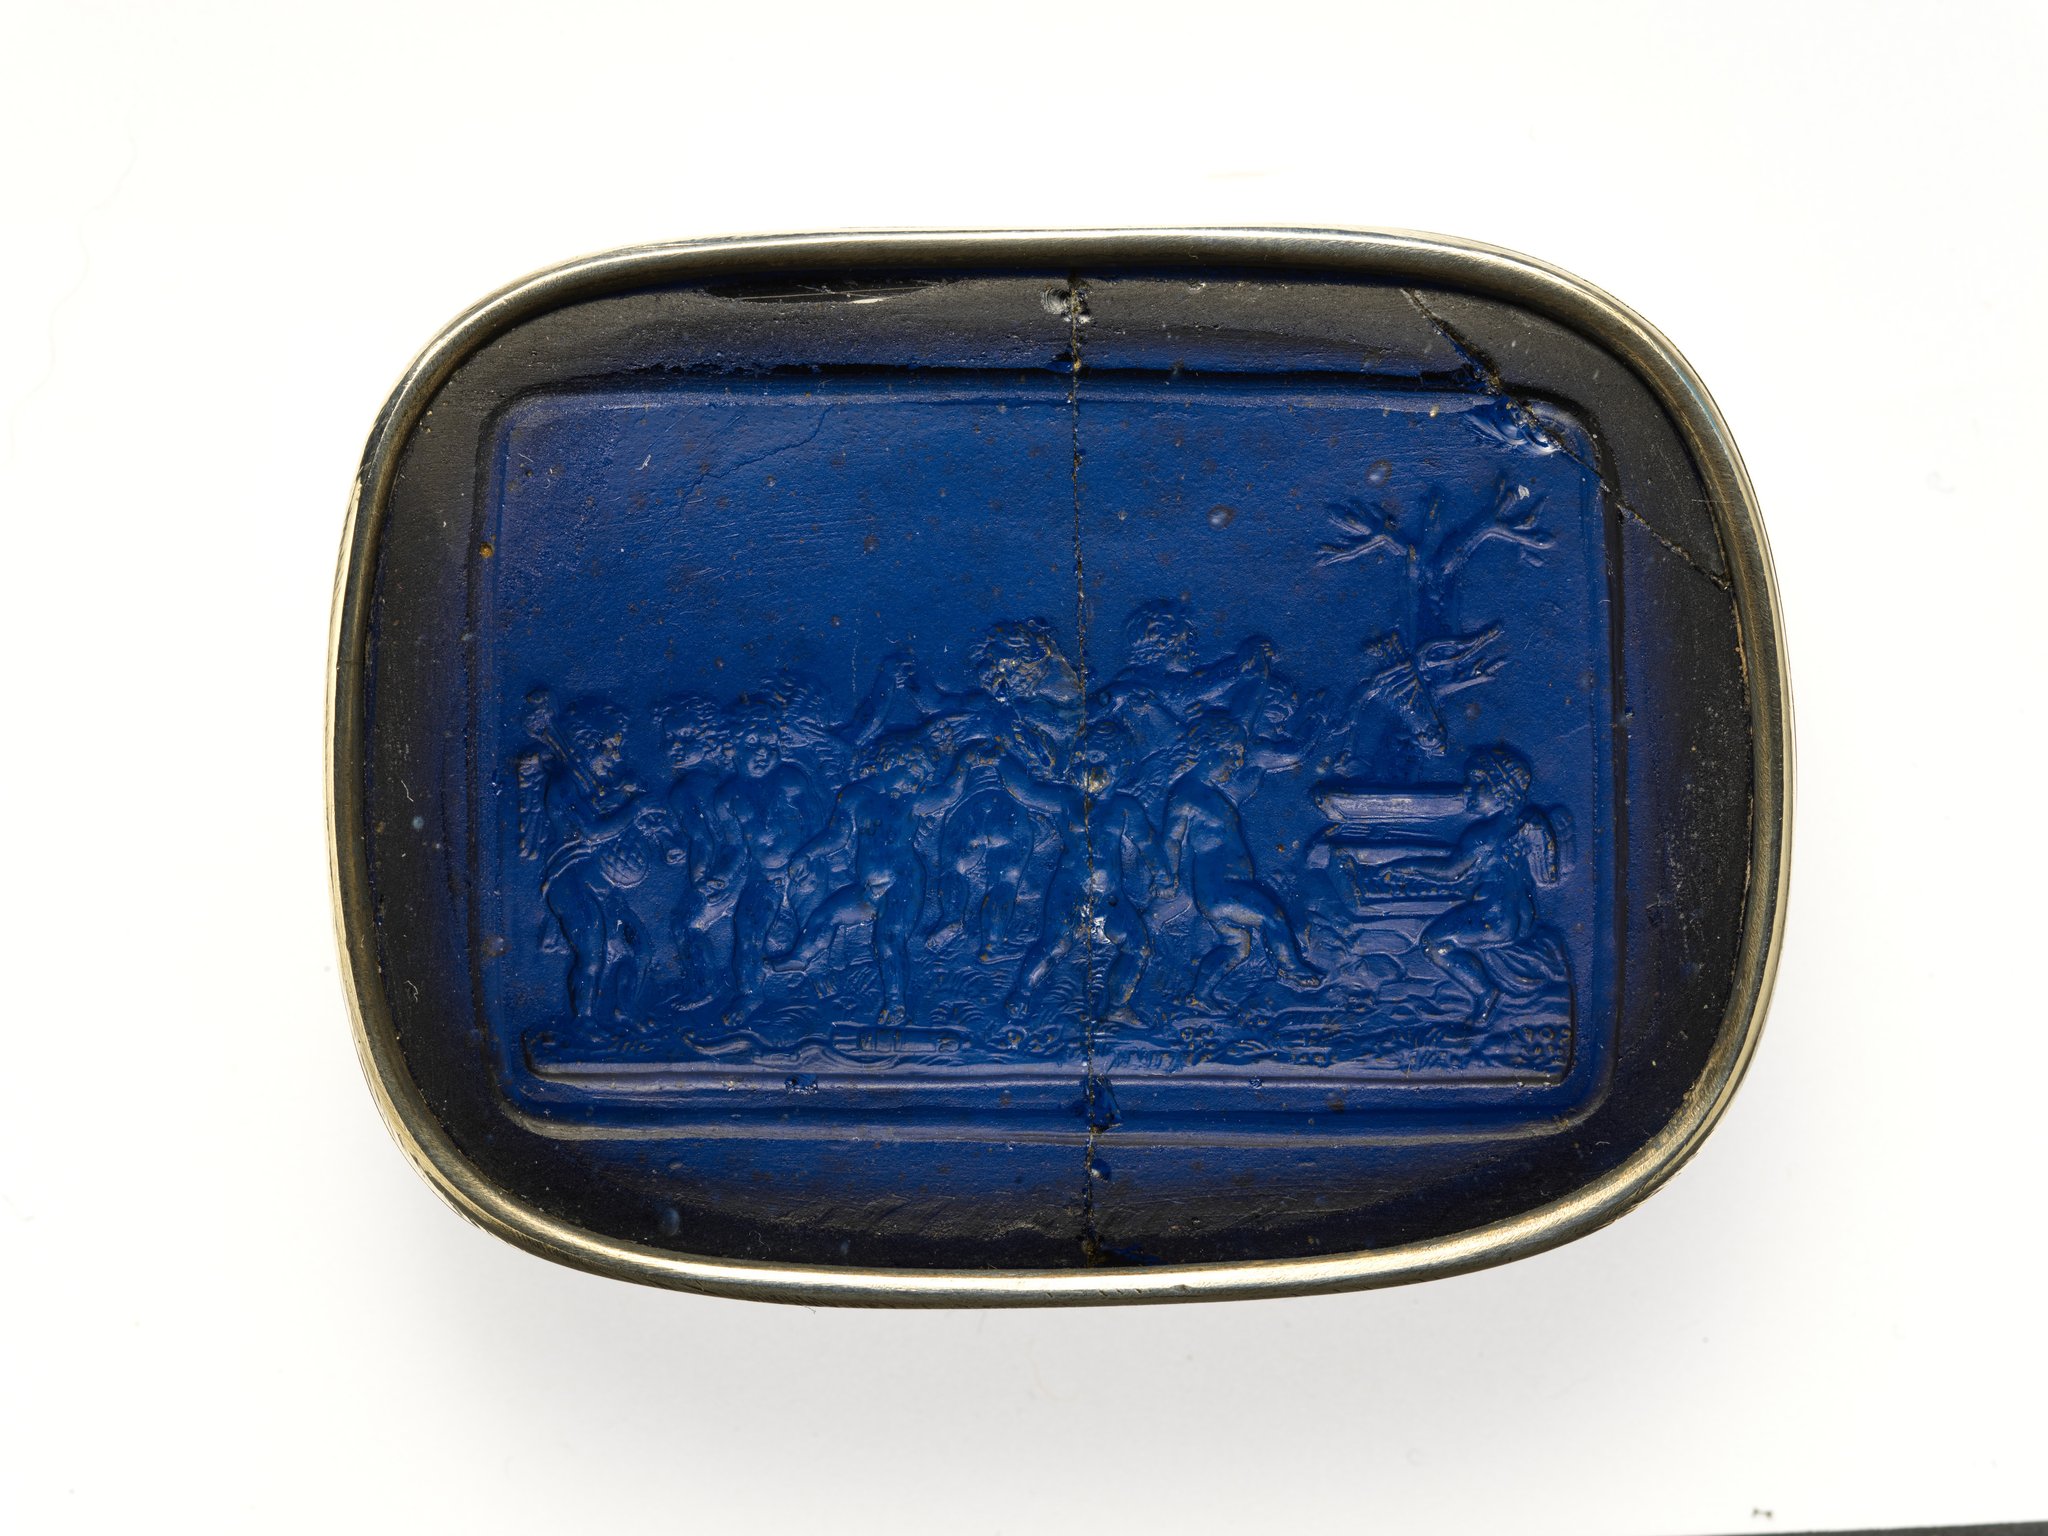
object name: plaque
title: Plaque with Revel of Erotes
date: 1767-1833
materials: glass, silver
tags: dancing,putti